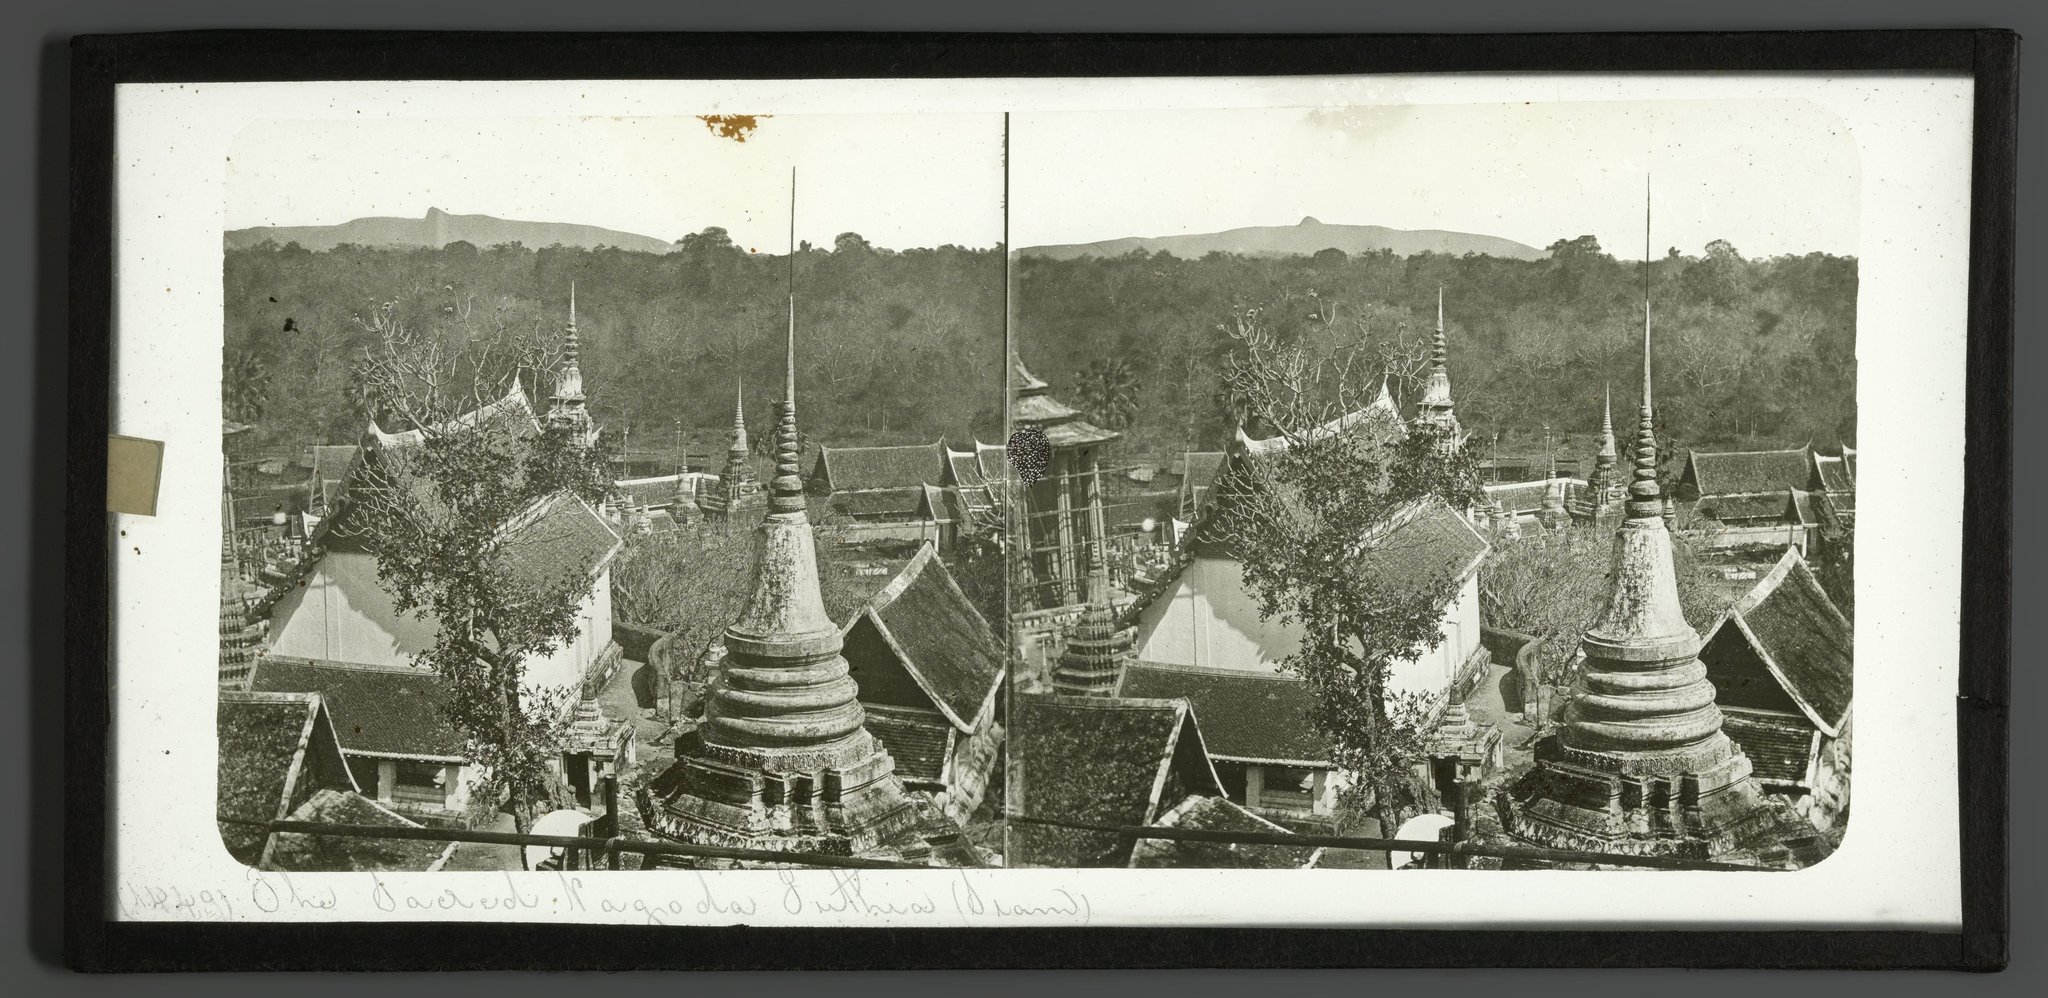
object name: stereoscopic photograph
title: Pagodes bij het tempelcomplex van Puthia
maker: Anonymous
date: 1860-1880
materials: glass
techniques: slide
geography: puthia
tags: temple, shrine ~ hinduism, buddhism, jainism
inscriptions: number: ‘1449’